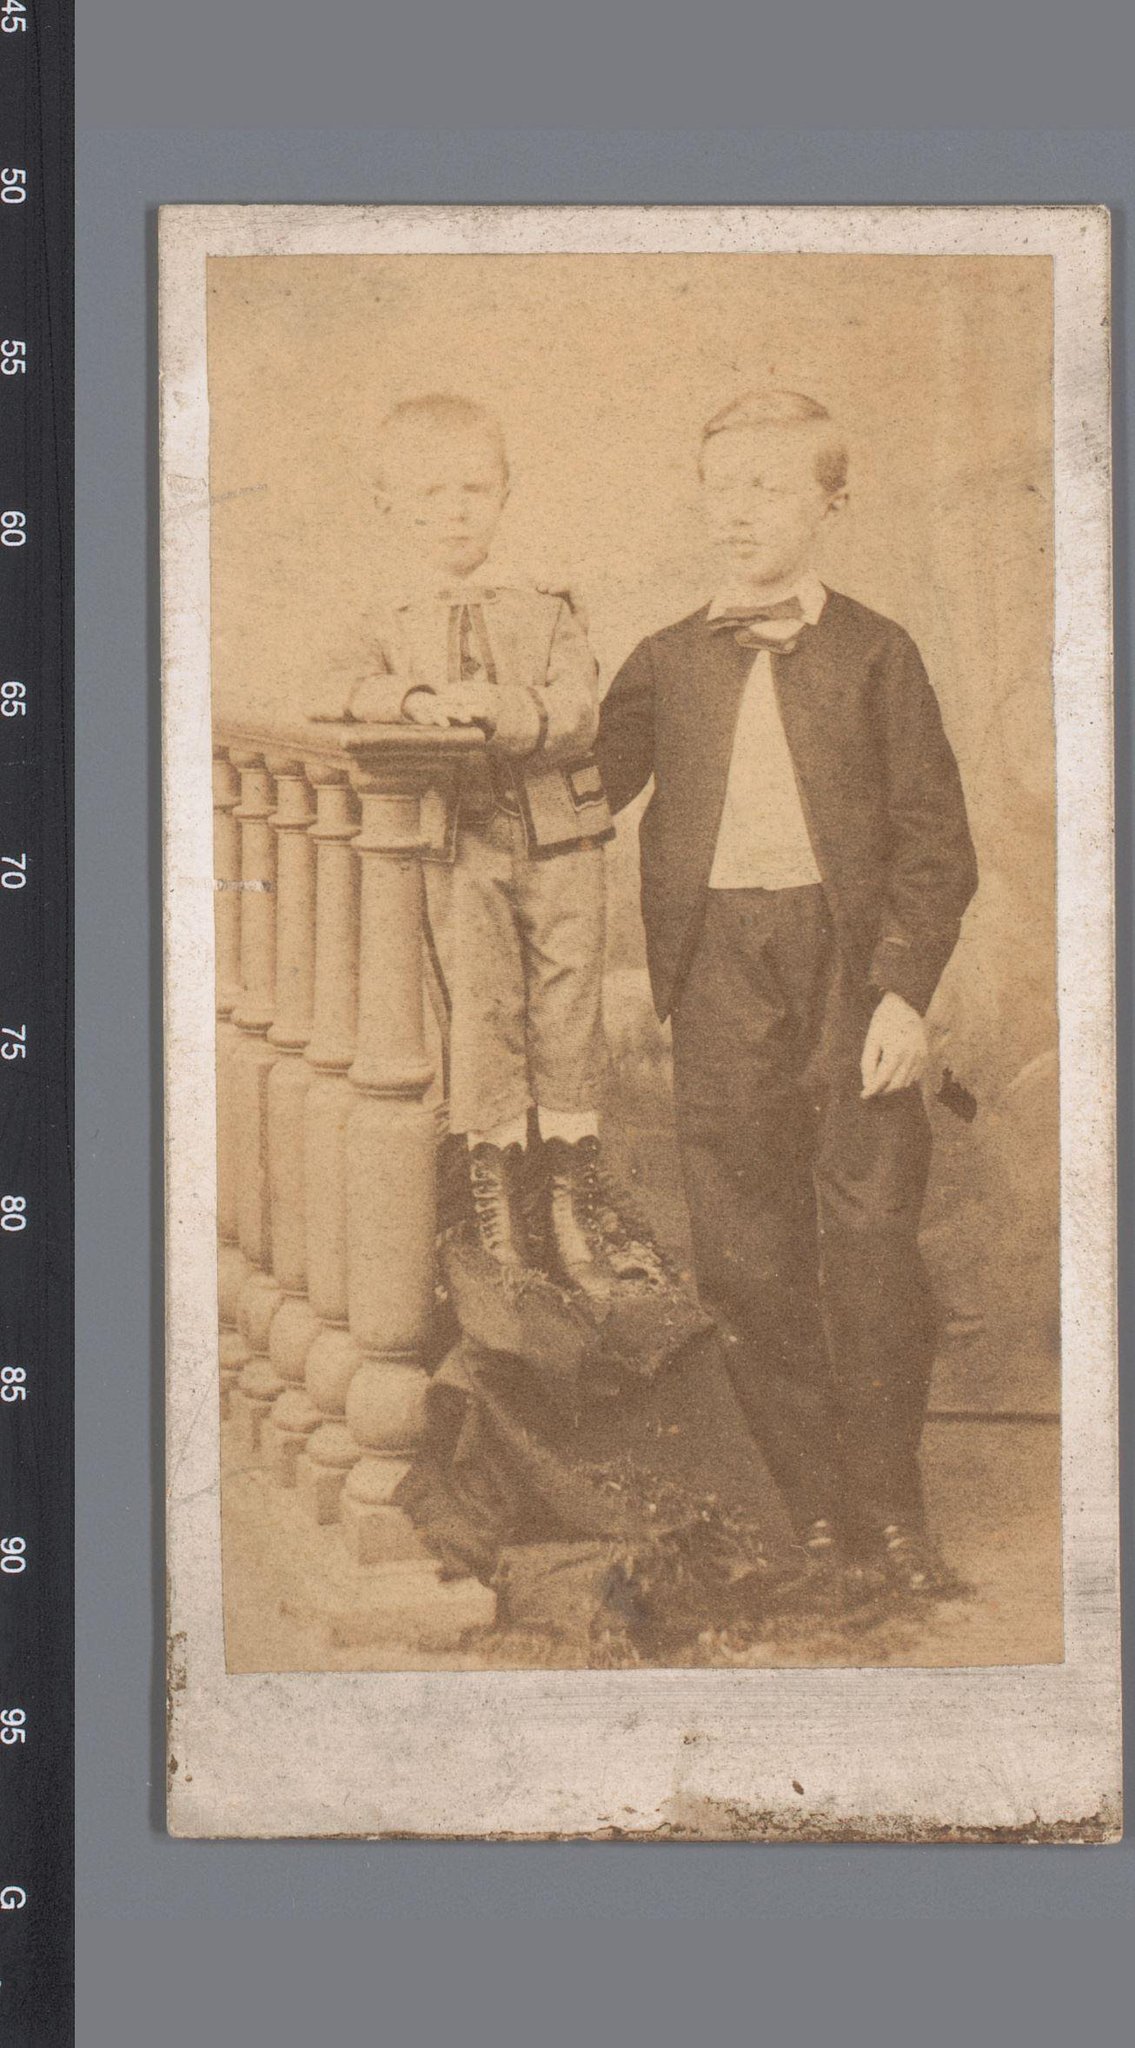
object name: carte de visite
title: Portret van twee onbekende jongens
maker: raverdy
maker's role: fotograaf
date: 1855-1885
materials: cardboard, paper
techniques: albumen print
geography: valenciennes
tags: boy (child between toddler and youth), anonymous historical person portrayed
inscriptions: address: ‘Rue St. Géry, 23/ VALENCIENNES/ (Nord)’